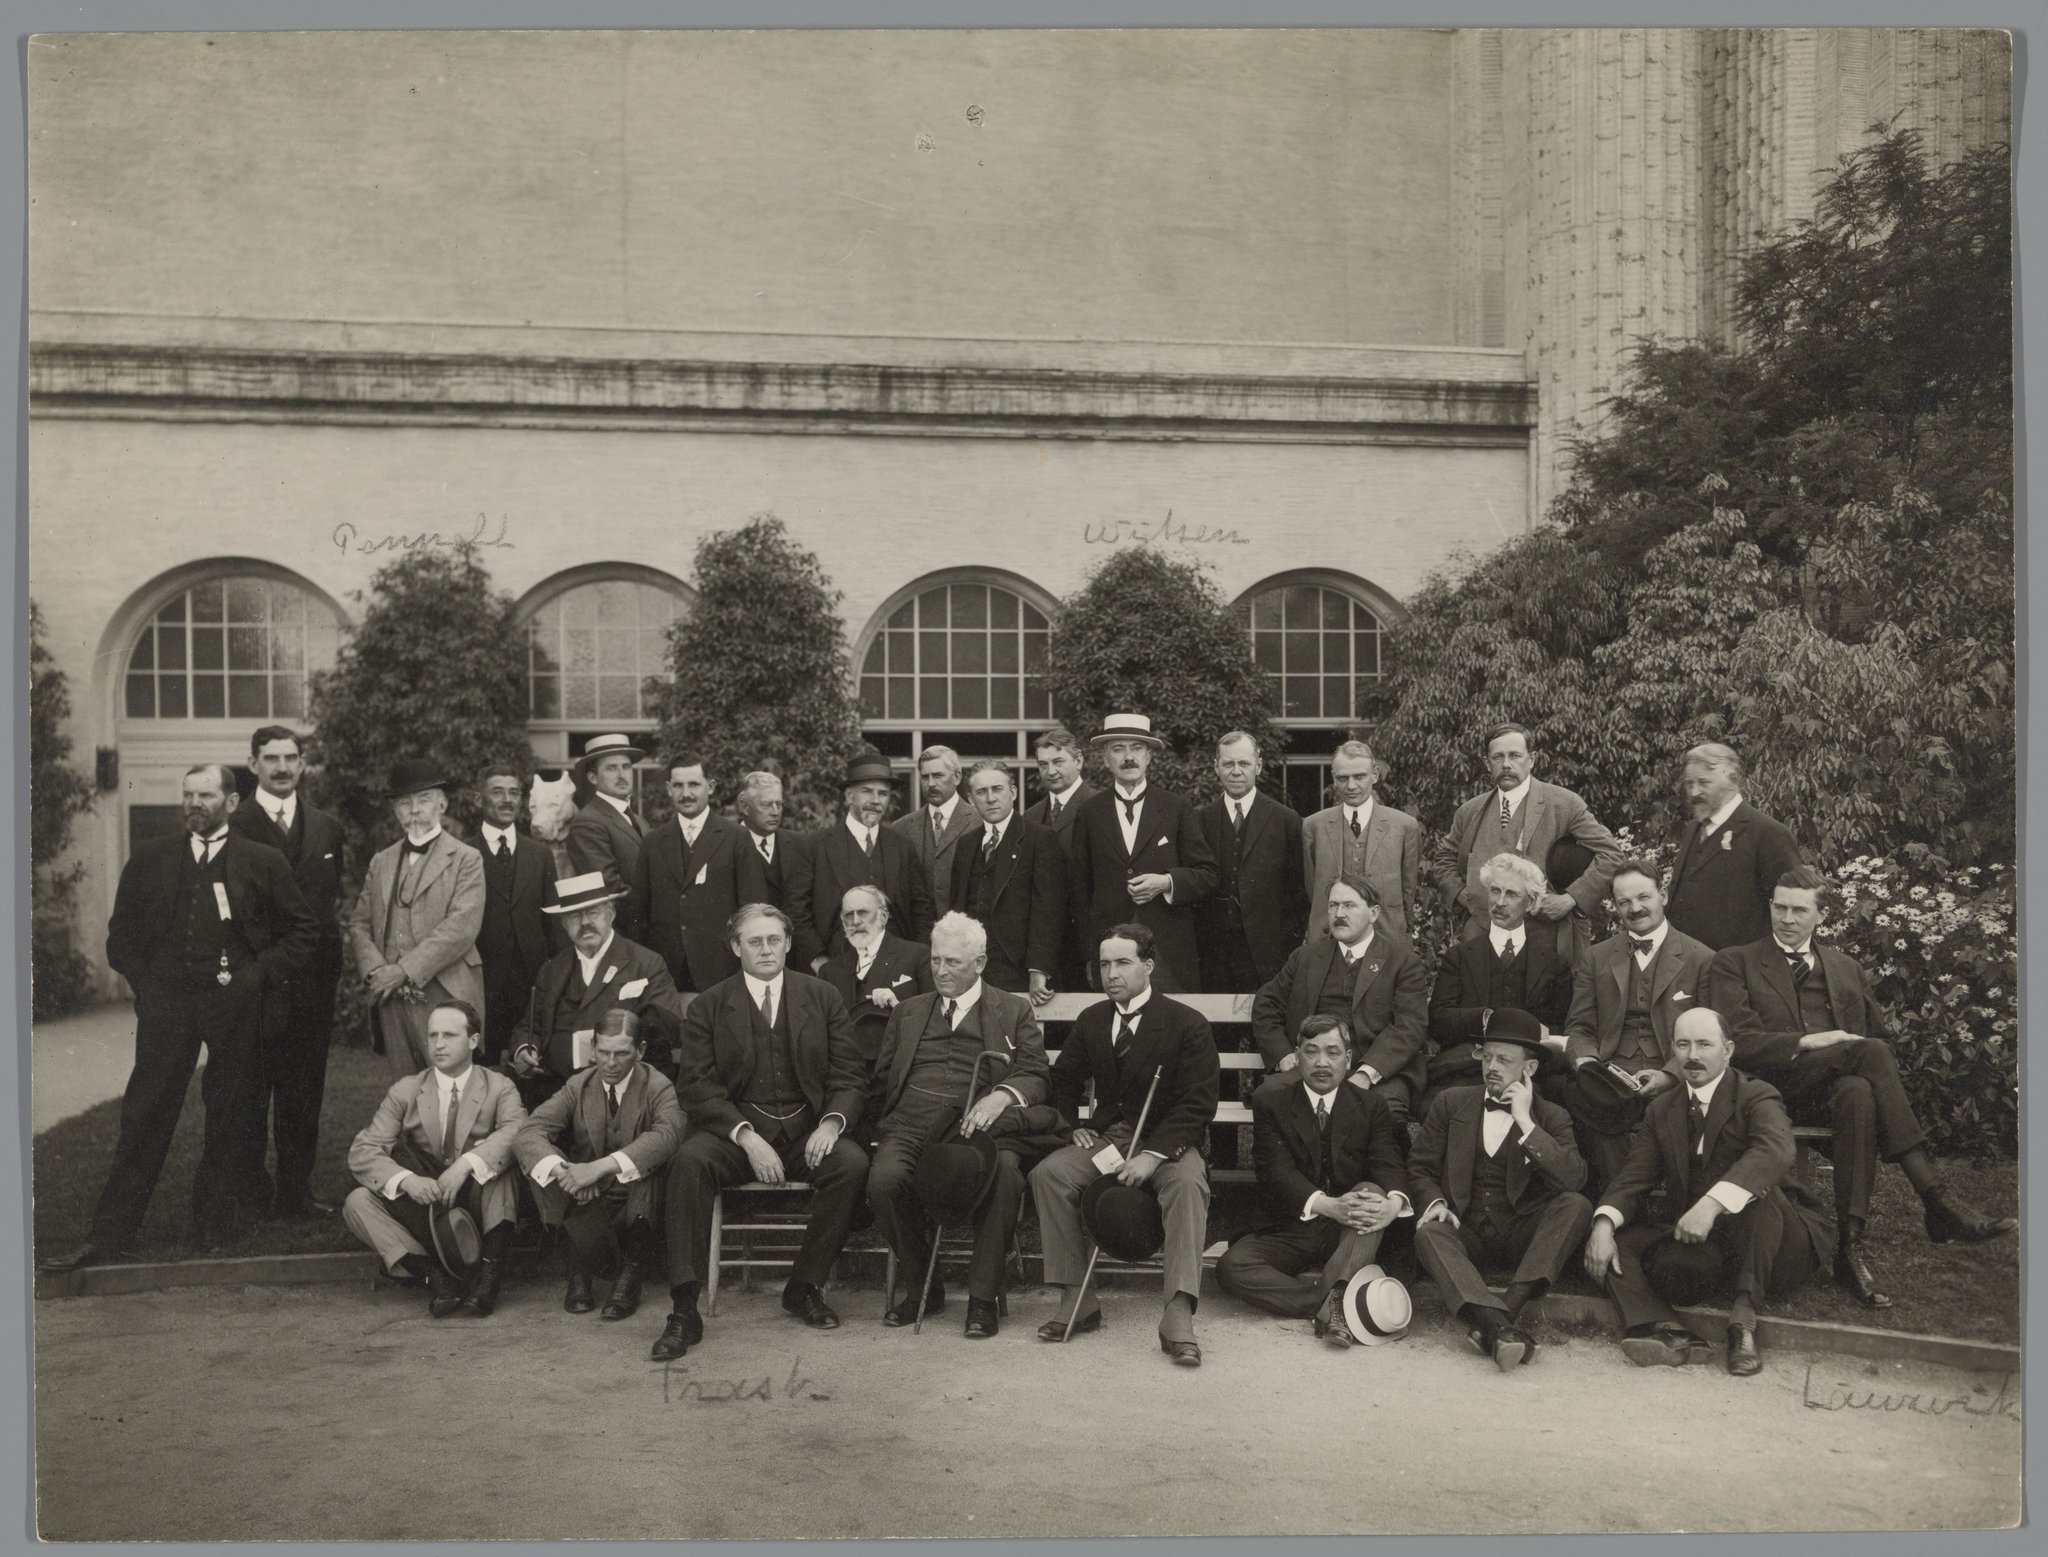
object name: photograph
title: Witsen met groep (San Francisco)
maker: gabriel moulin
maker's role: fotograaf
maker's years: 1872-1945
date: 1860-1915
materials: paper, photographic support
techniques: gelatin silver print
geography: san francisco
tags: amsterdam, painter, print maker, draughtsman, willem witsen